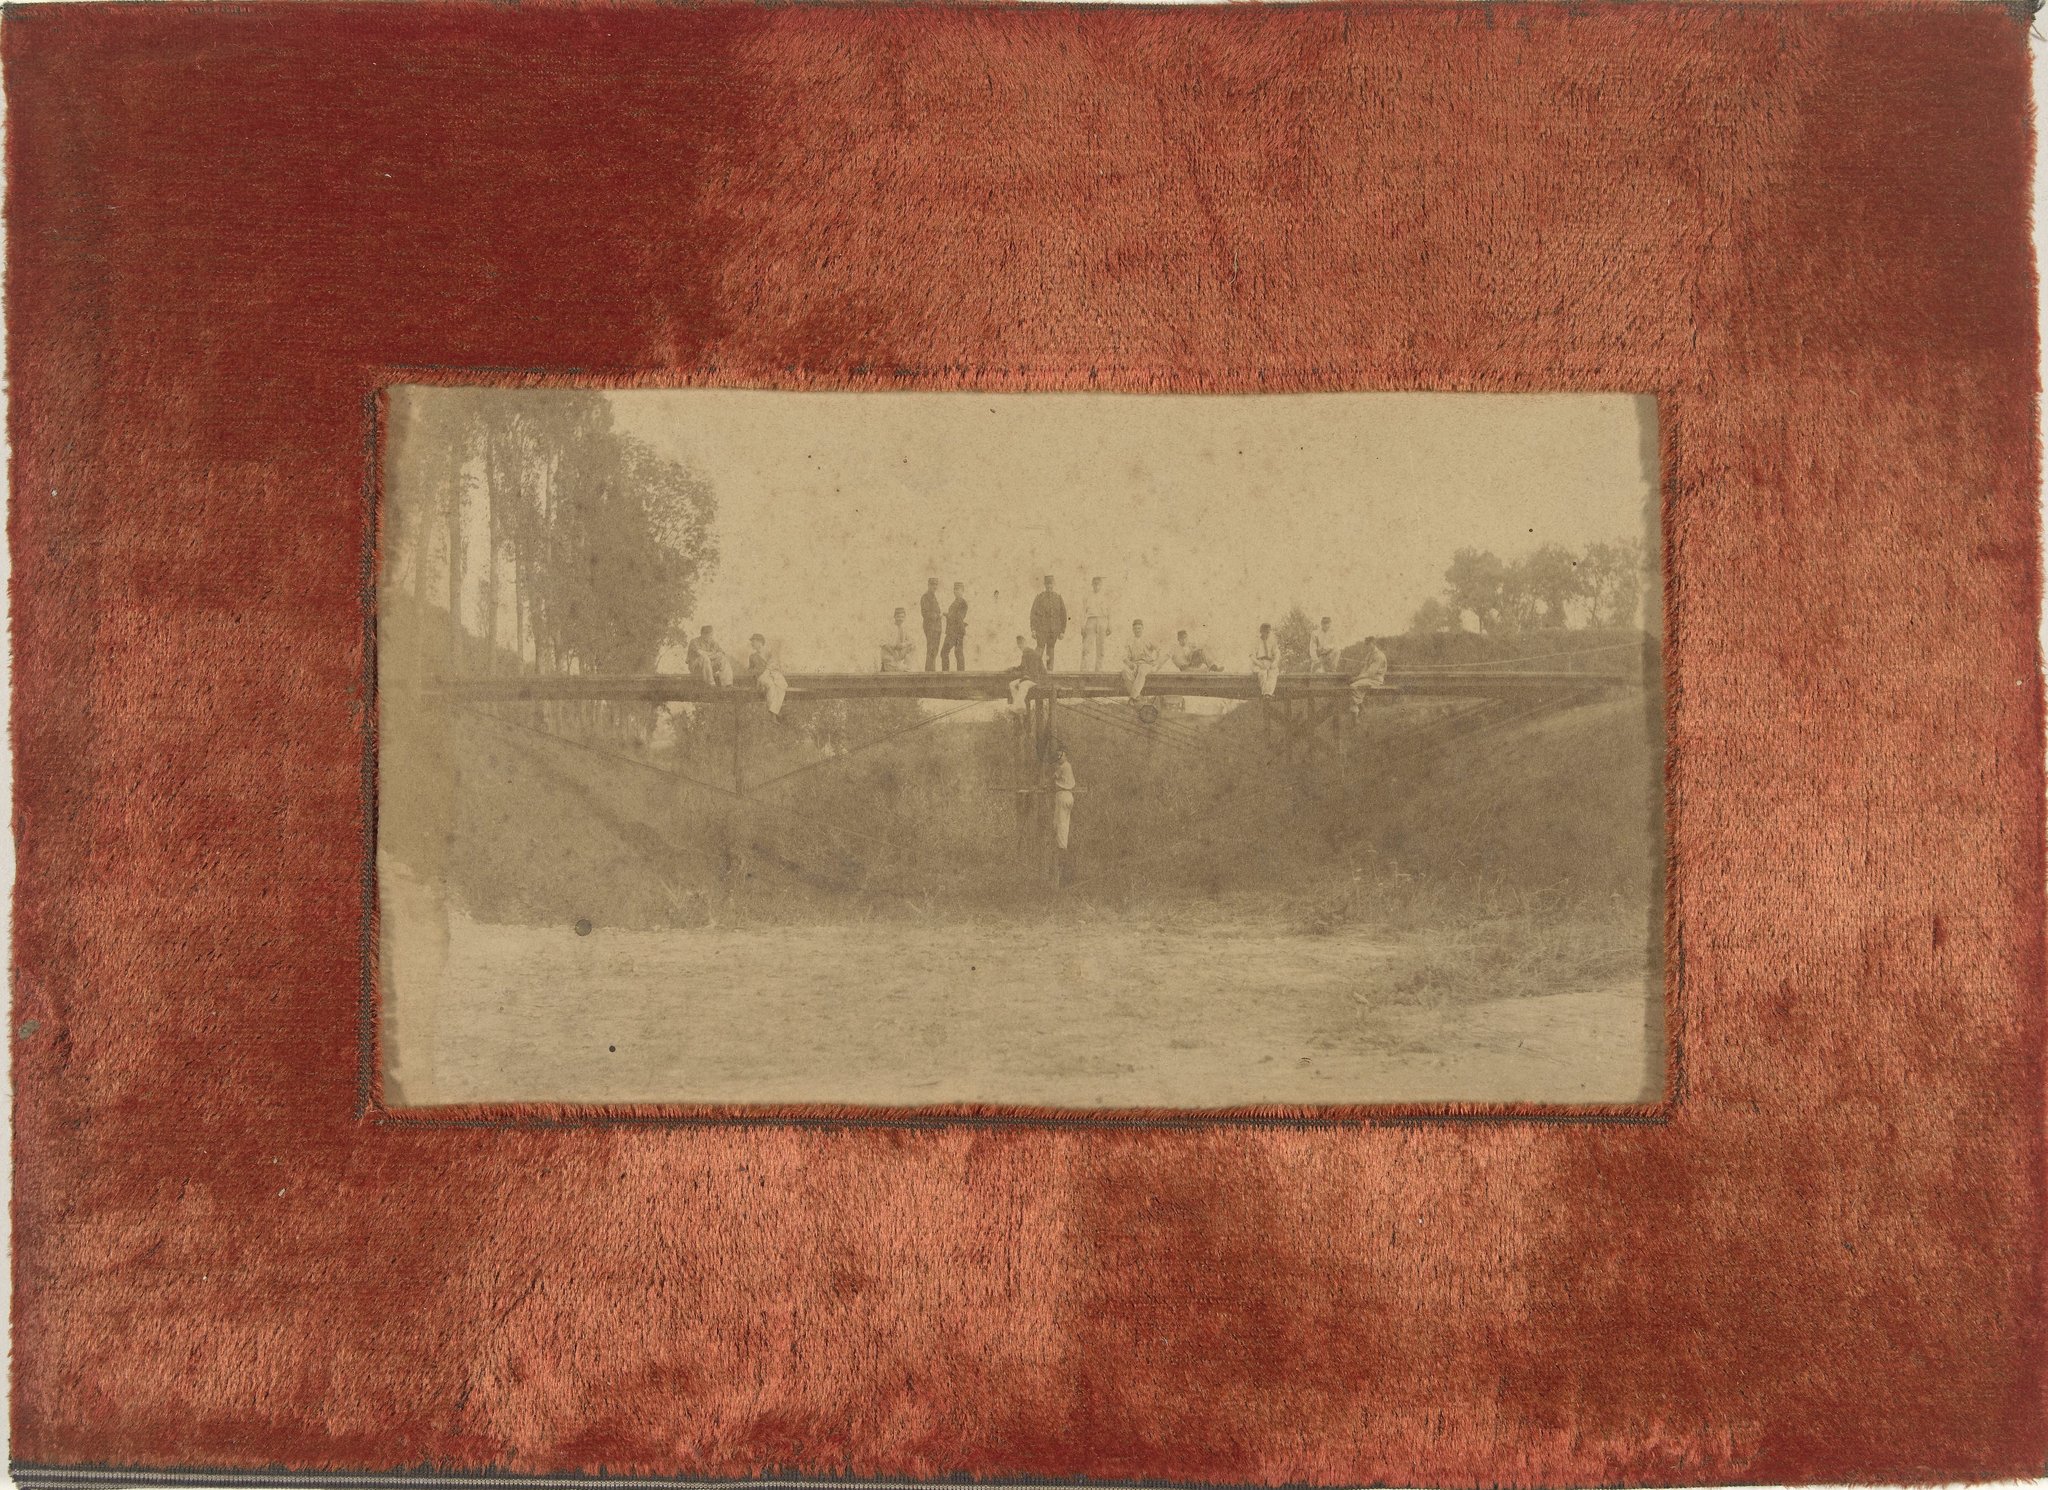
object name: photograph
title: Groepsportret van onbekende mannen op een brug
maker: Anonymous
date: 1870-1900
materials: cardboard, paper, velvet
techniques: albumen print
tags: historical persons, bridge